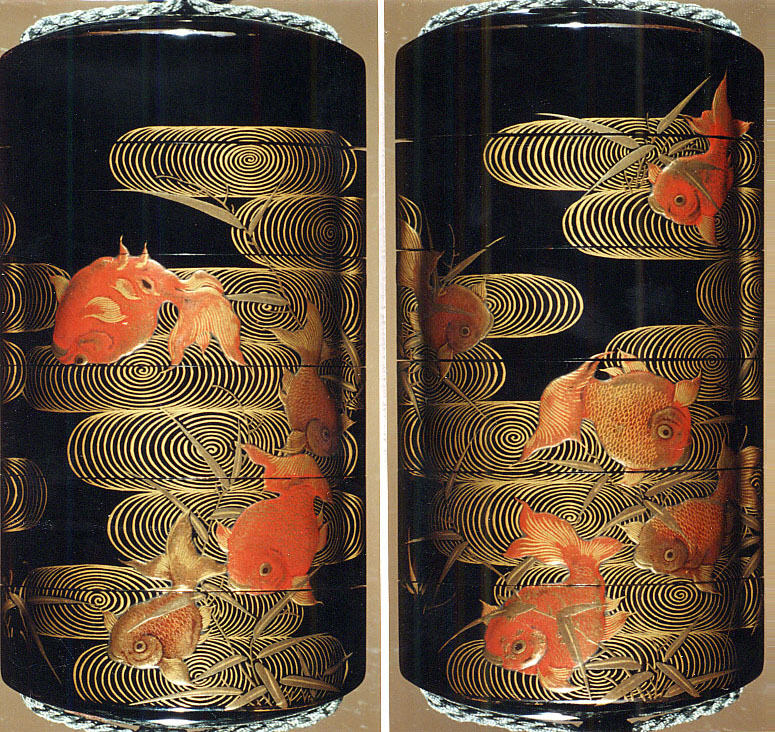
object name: inrō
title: Case (Inrō) with Design of Goldfish and Reed with Wave Pattern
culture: japanese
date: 1701-1900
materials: gold, lacquer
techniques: fundame, hiramakie, roiro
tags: fish,plants,waves